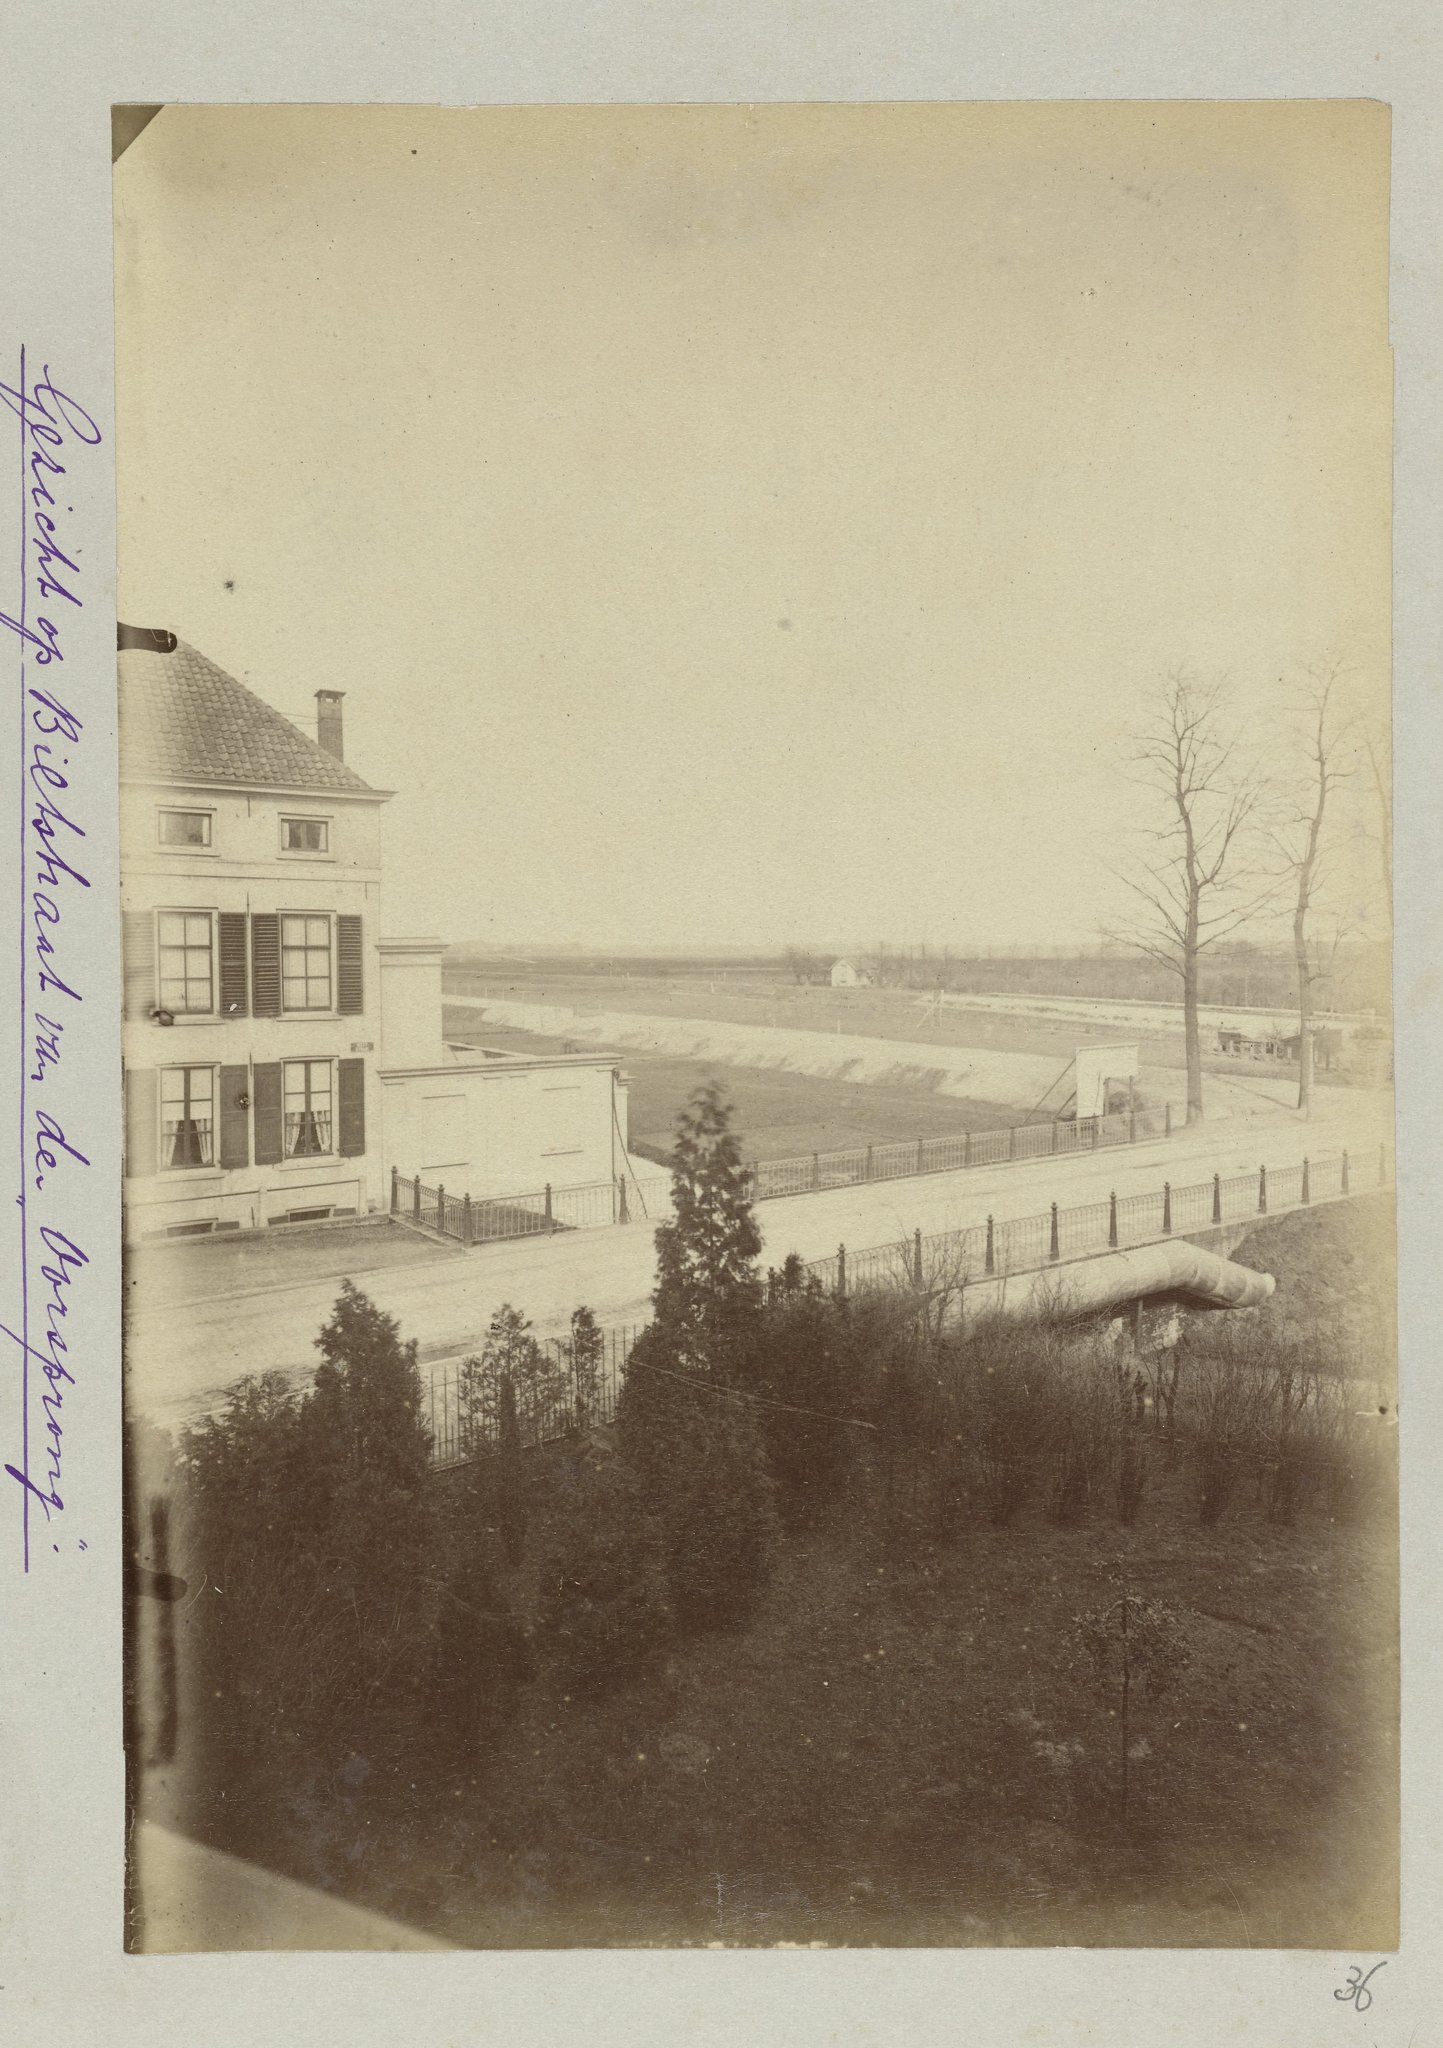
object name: photograph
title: Gezicht op de Biltstraat vanuit herenhuis De Oorsprong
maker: henry pauw van wieldrecht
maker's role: fotograaf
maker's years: 1863-1912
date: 1888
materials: paper, photographic support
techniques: albumen print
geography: netherlands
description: Links op het albumblad geschreven: Gezicht op de Biltstraat van Den Oorsprong.